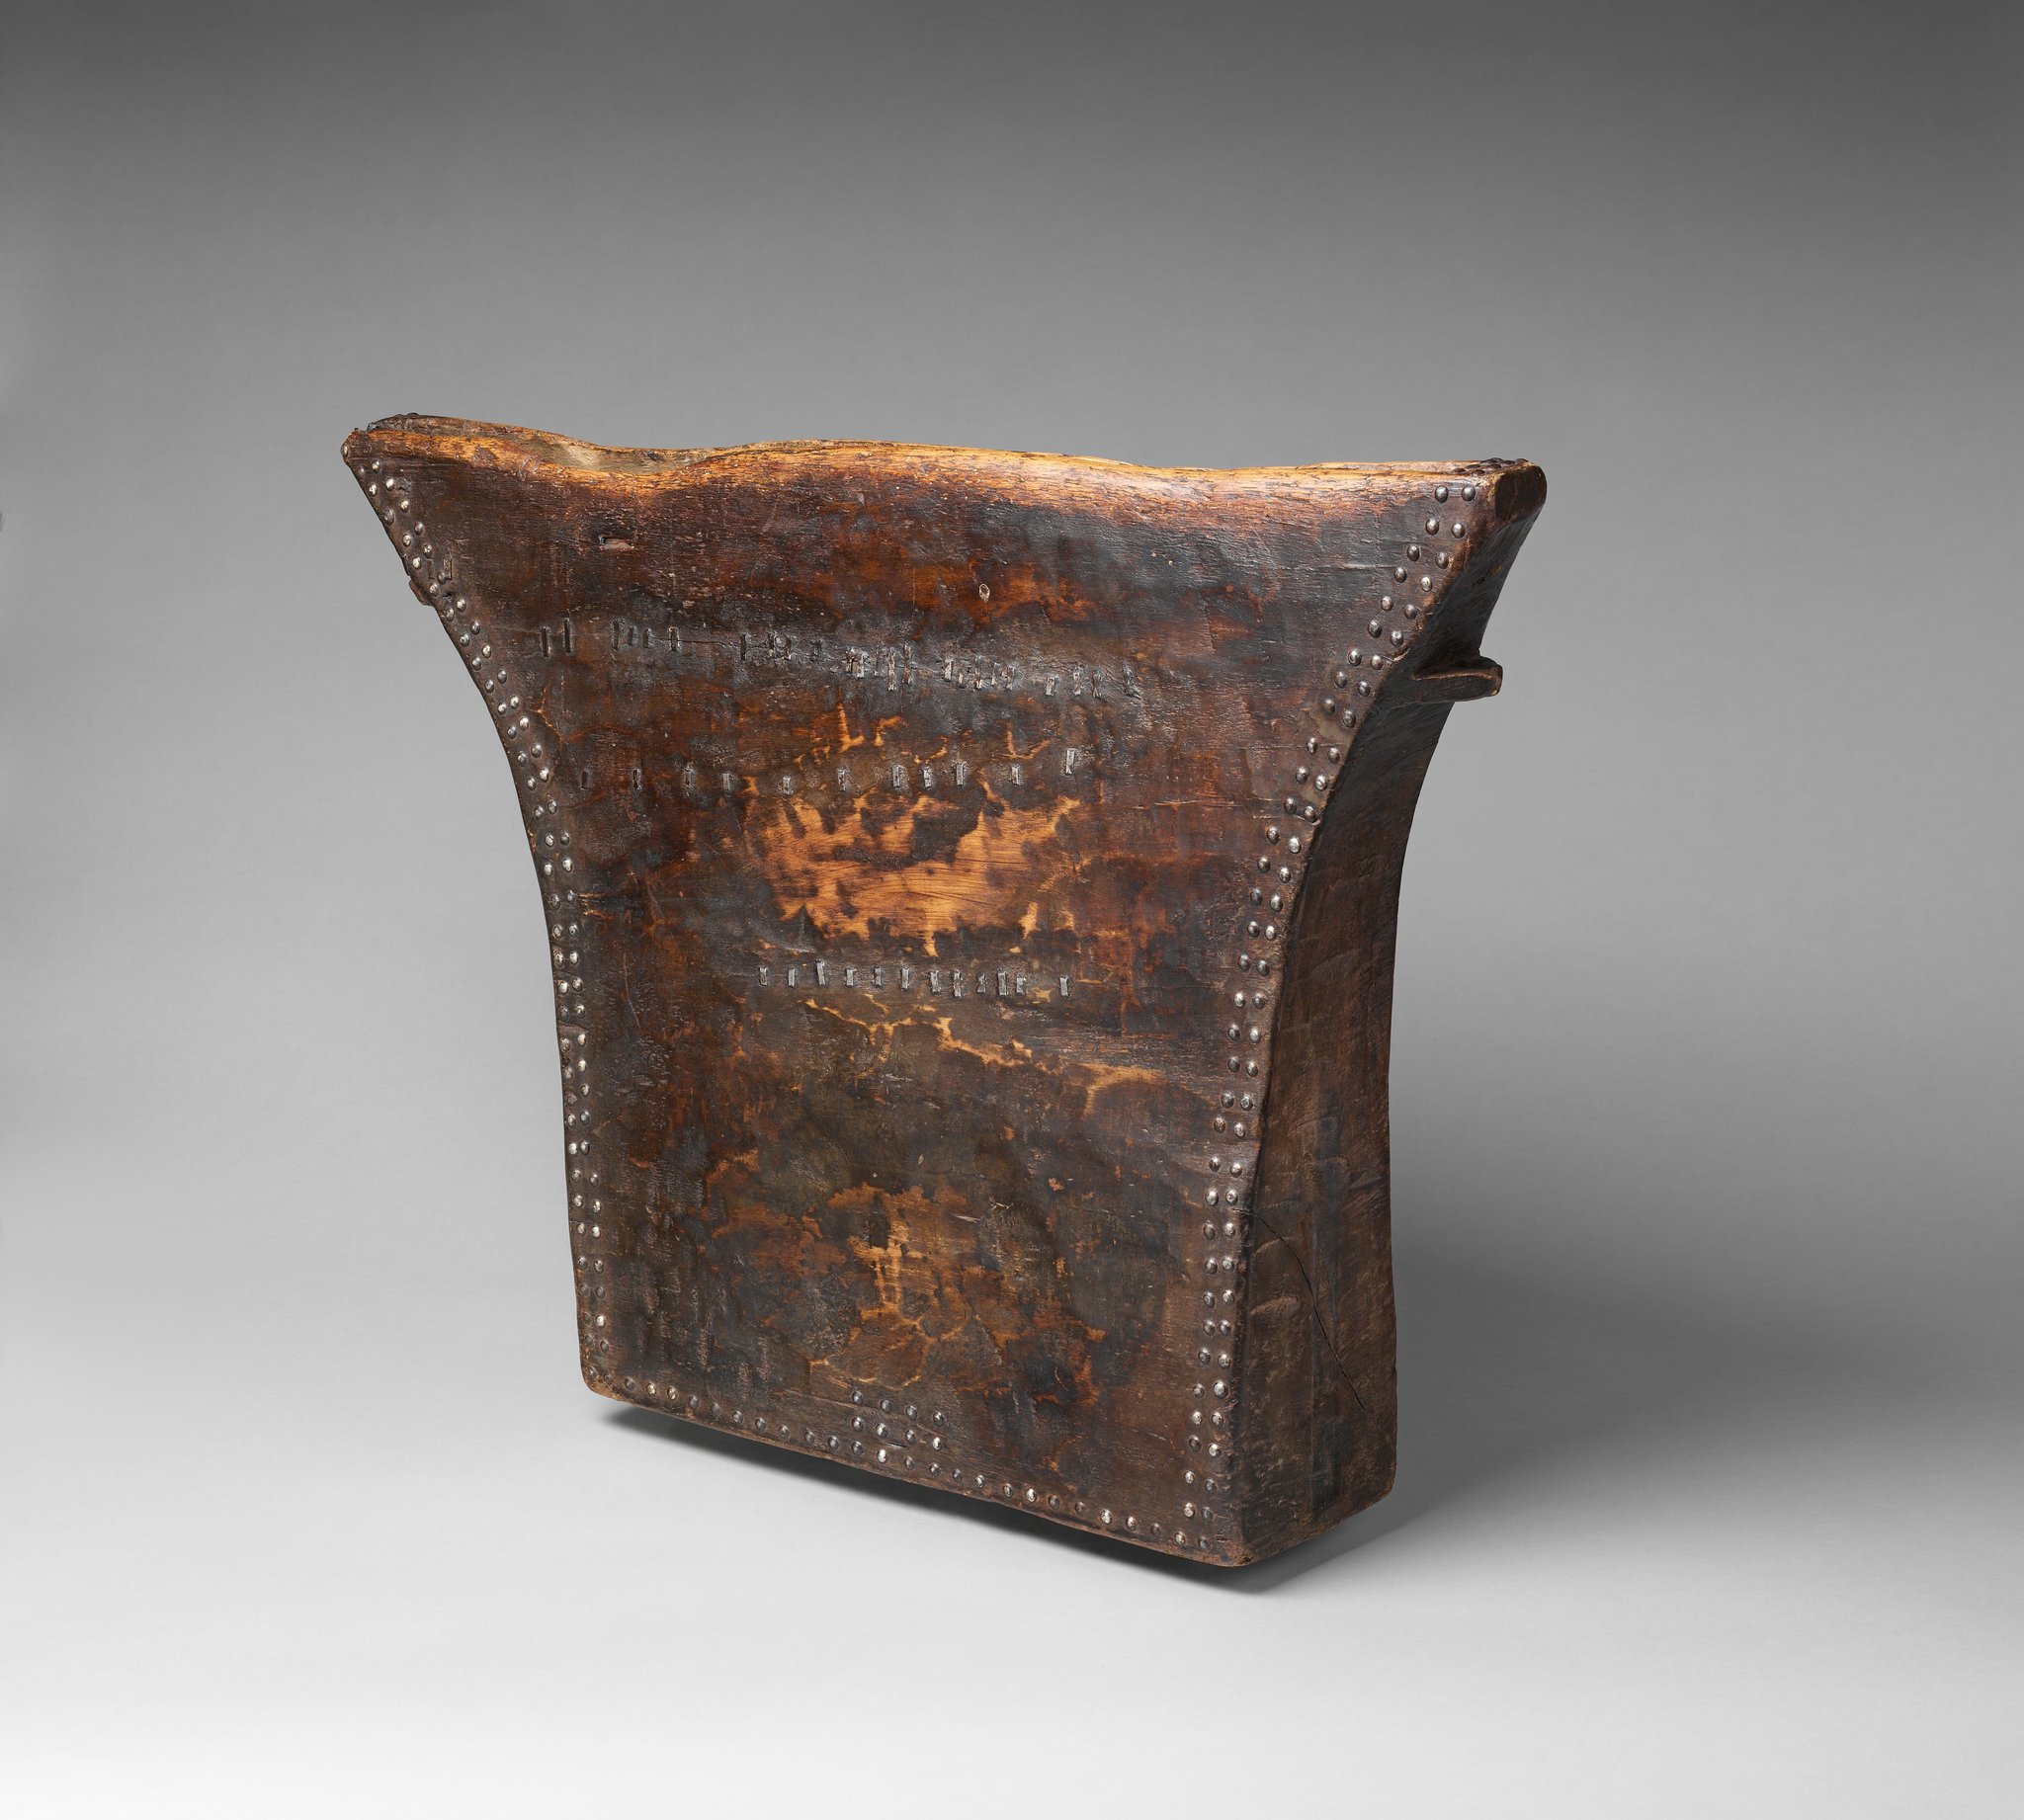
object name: lukombé slit drum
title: Lukombé (slit drum)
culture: tetela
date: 1900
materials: metal, wood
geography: democratic republic of the congo